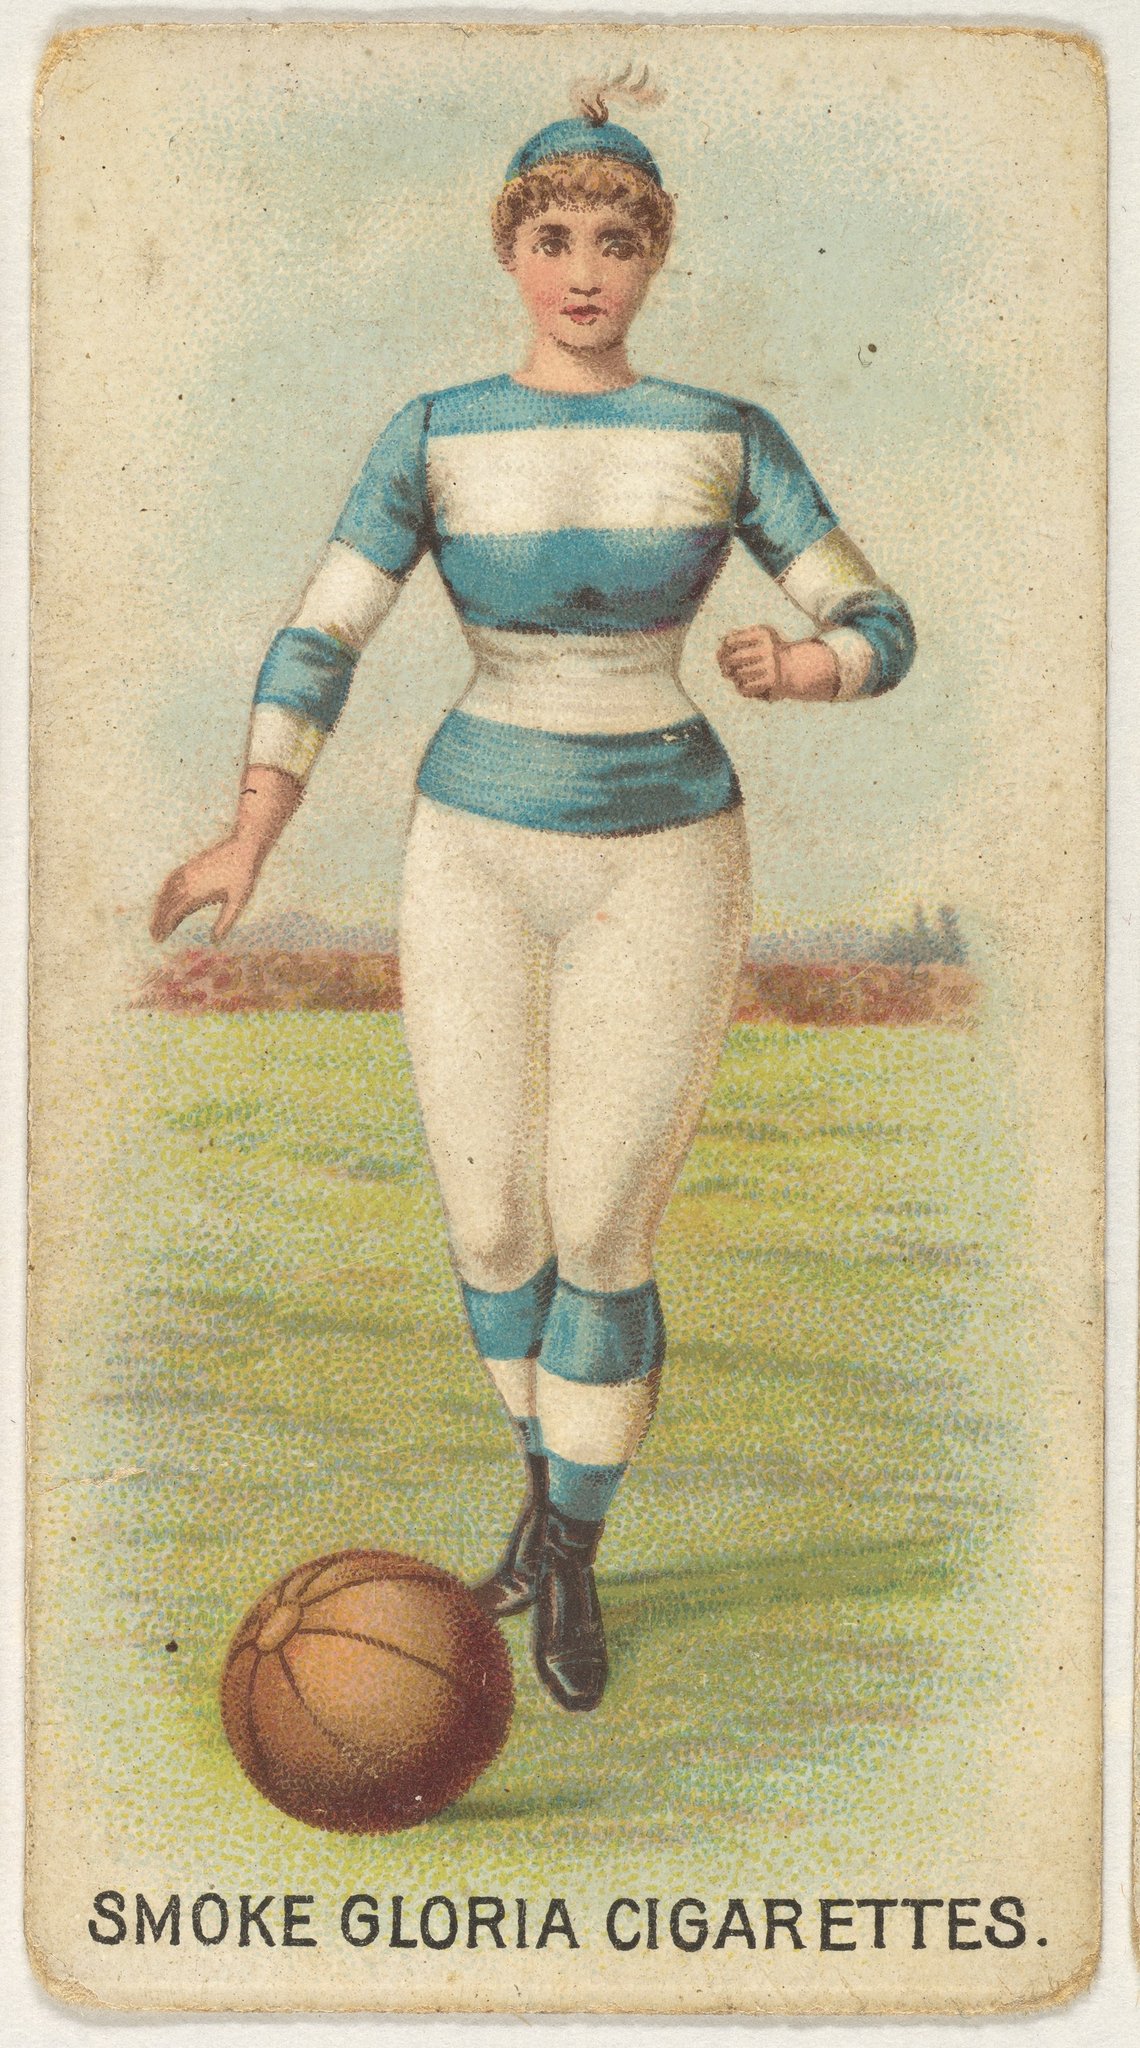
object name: print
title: From the series "Sports Girls" (C190), issued by the American Cigarette Company, Ltd., Montreal, to promote Gloria Cigarettes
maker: american cigarette company, ltd.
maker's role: publisher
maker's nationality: canadian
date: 1889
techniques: color lithograph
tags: women,sports